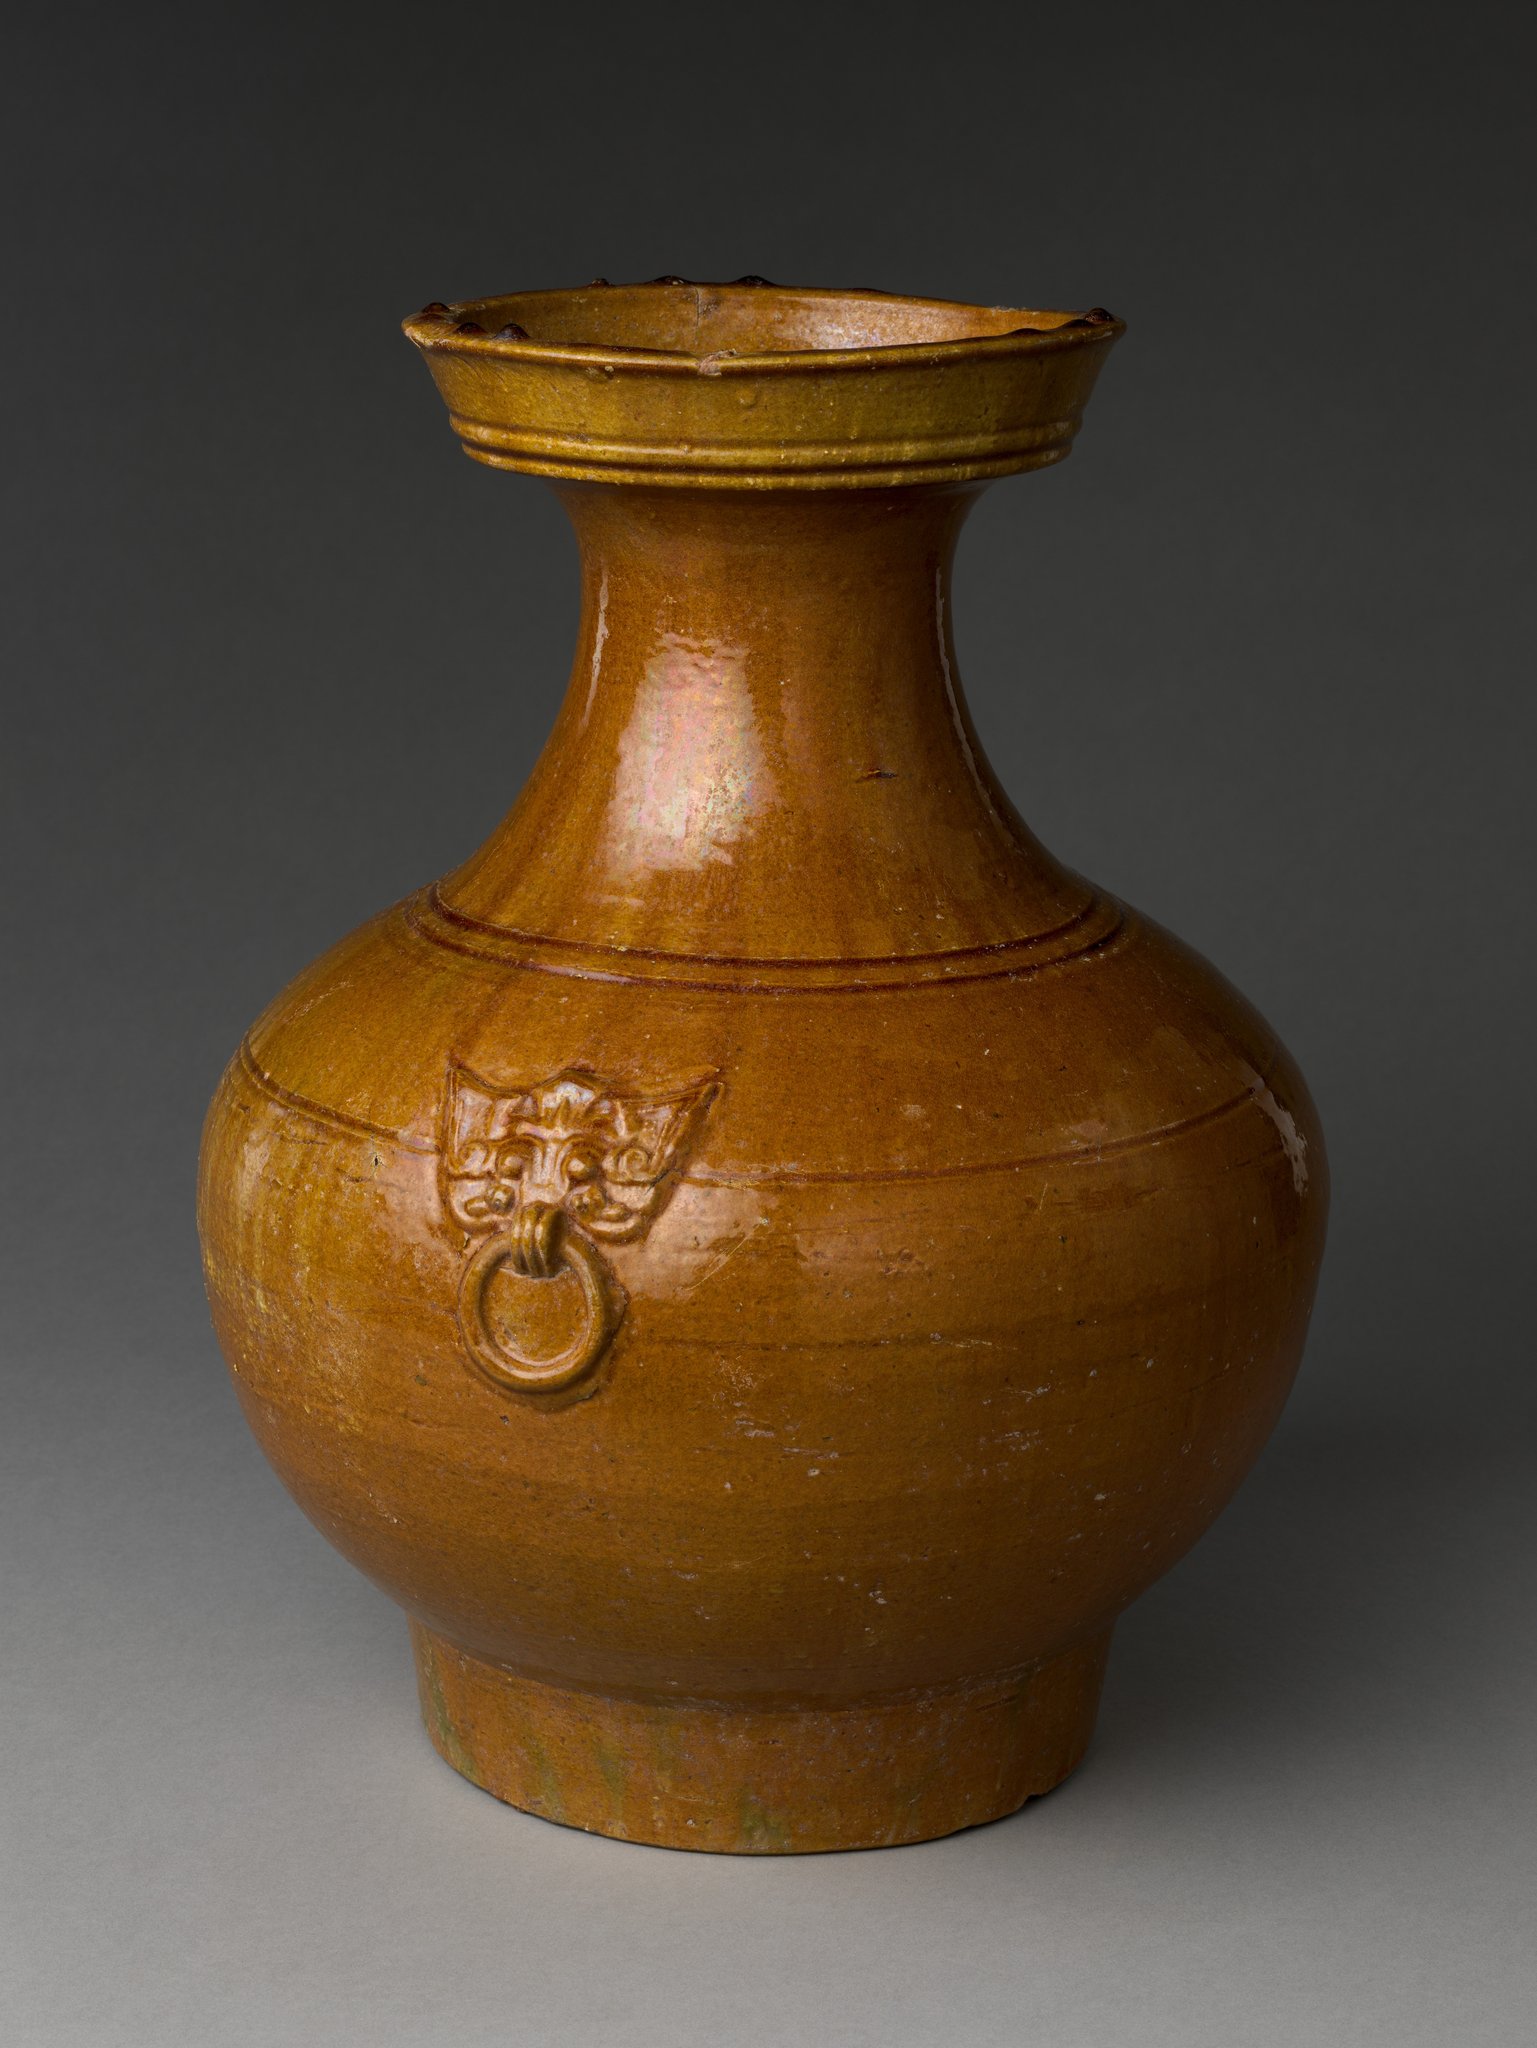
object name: jar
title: Jar in Shape of Archaic Bronze Vessel (Hu)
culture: chinese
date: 1-300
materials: amber, earthenware, glaze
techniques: incising